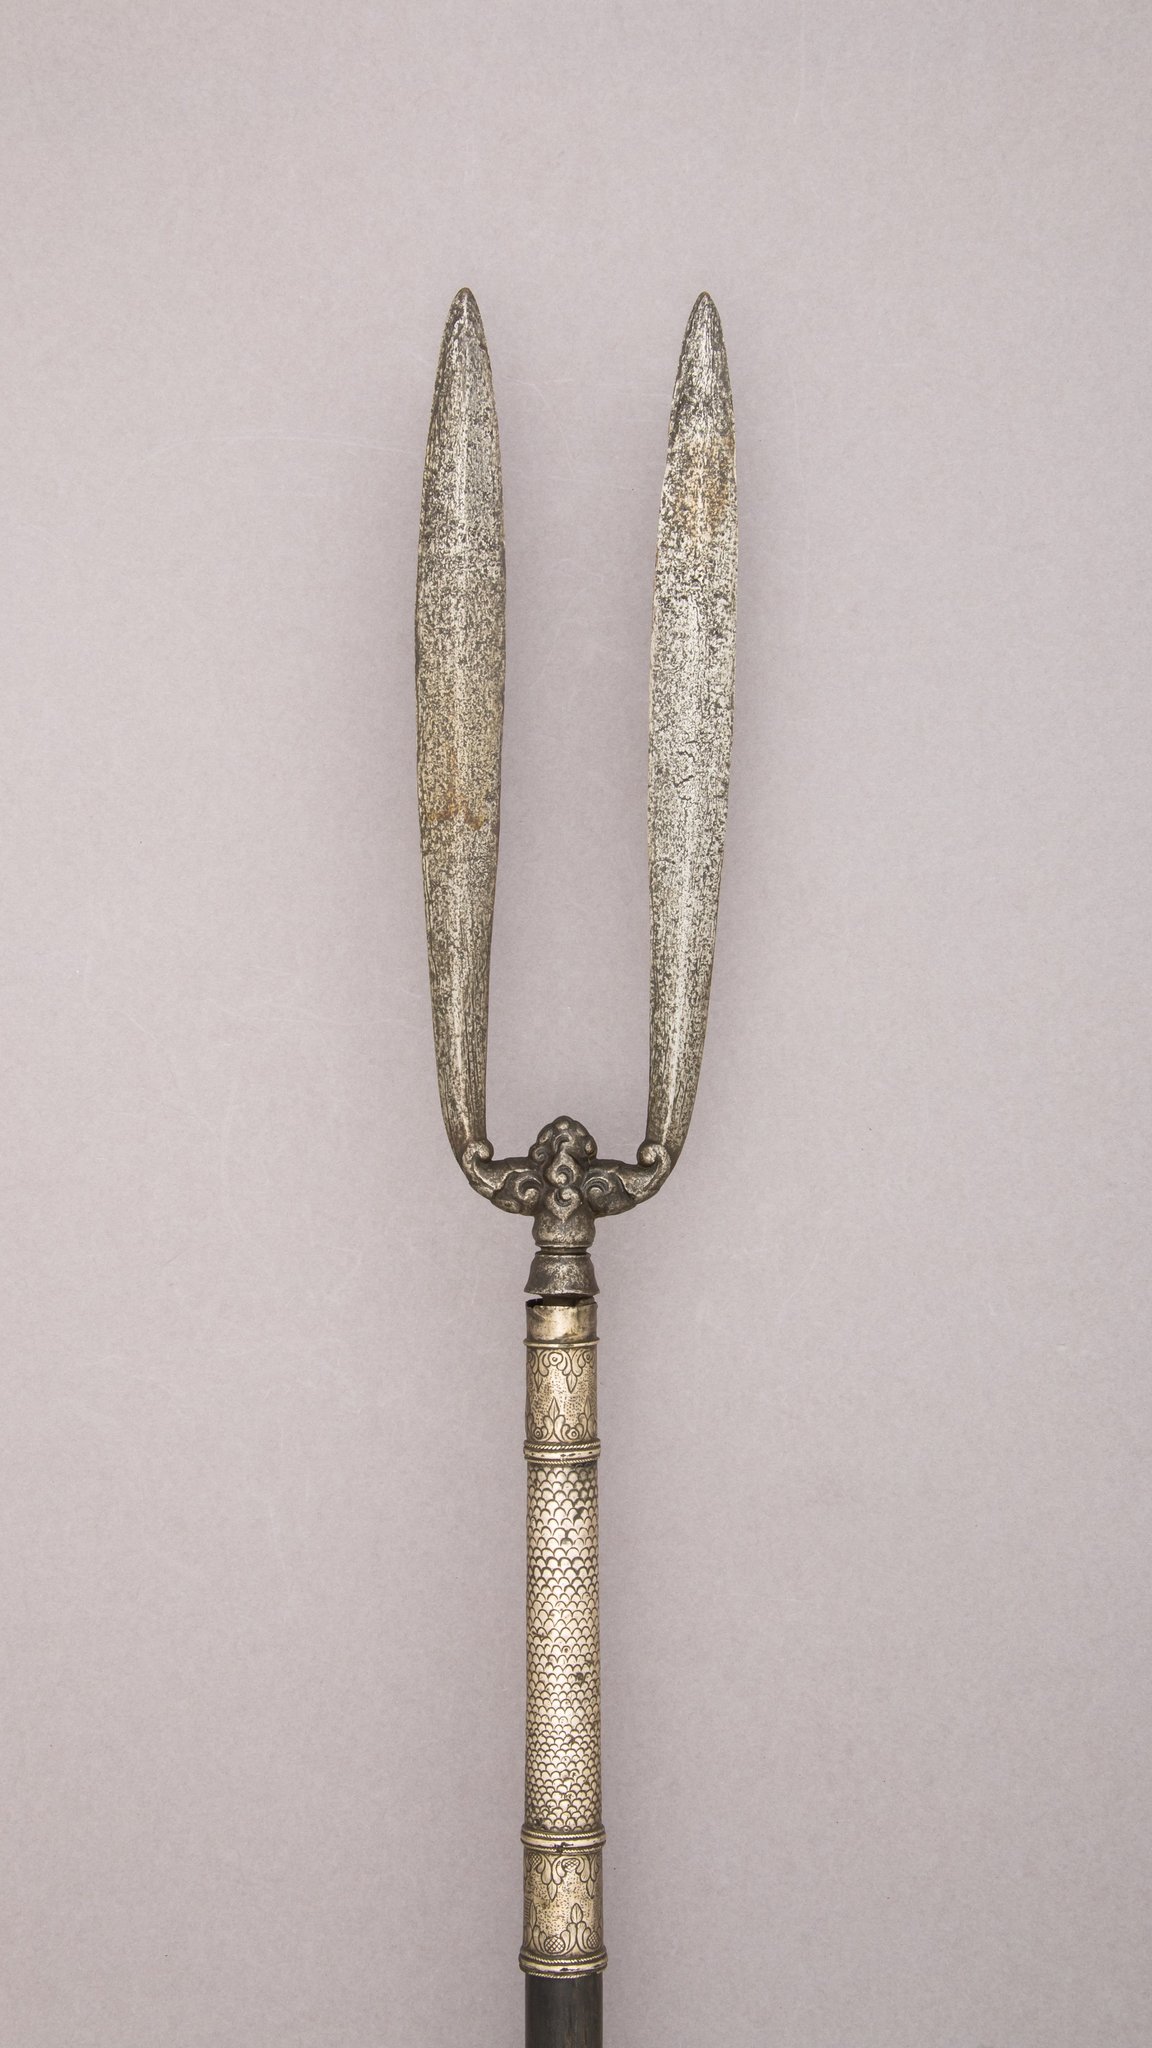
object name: two pronged spear bident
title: Two Pronged Spear (Bident)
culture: javanese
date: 1501-1900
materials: hair, silver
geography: indonesia